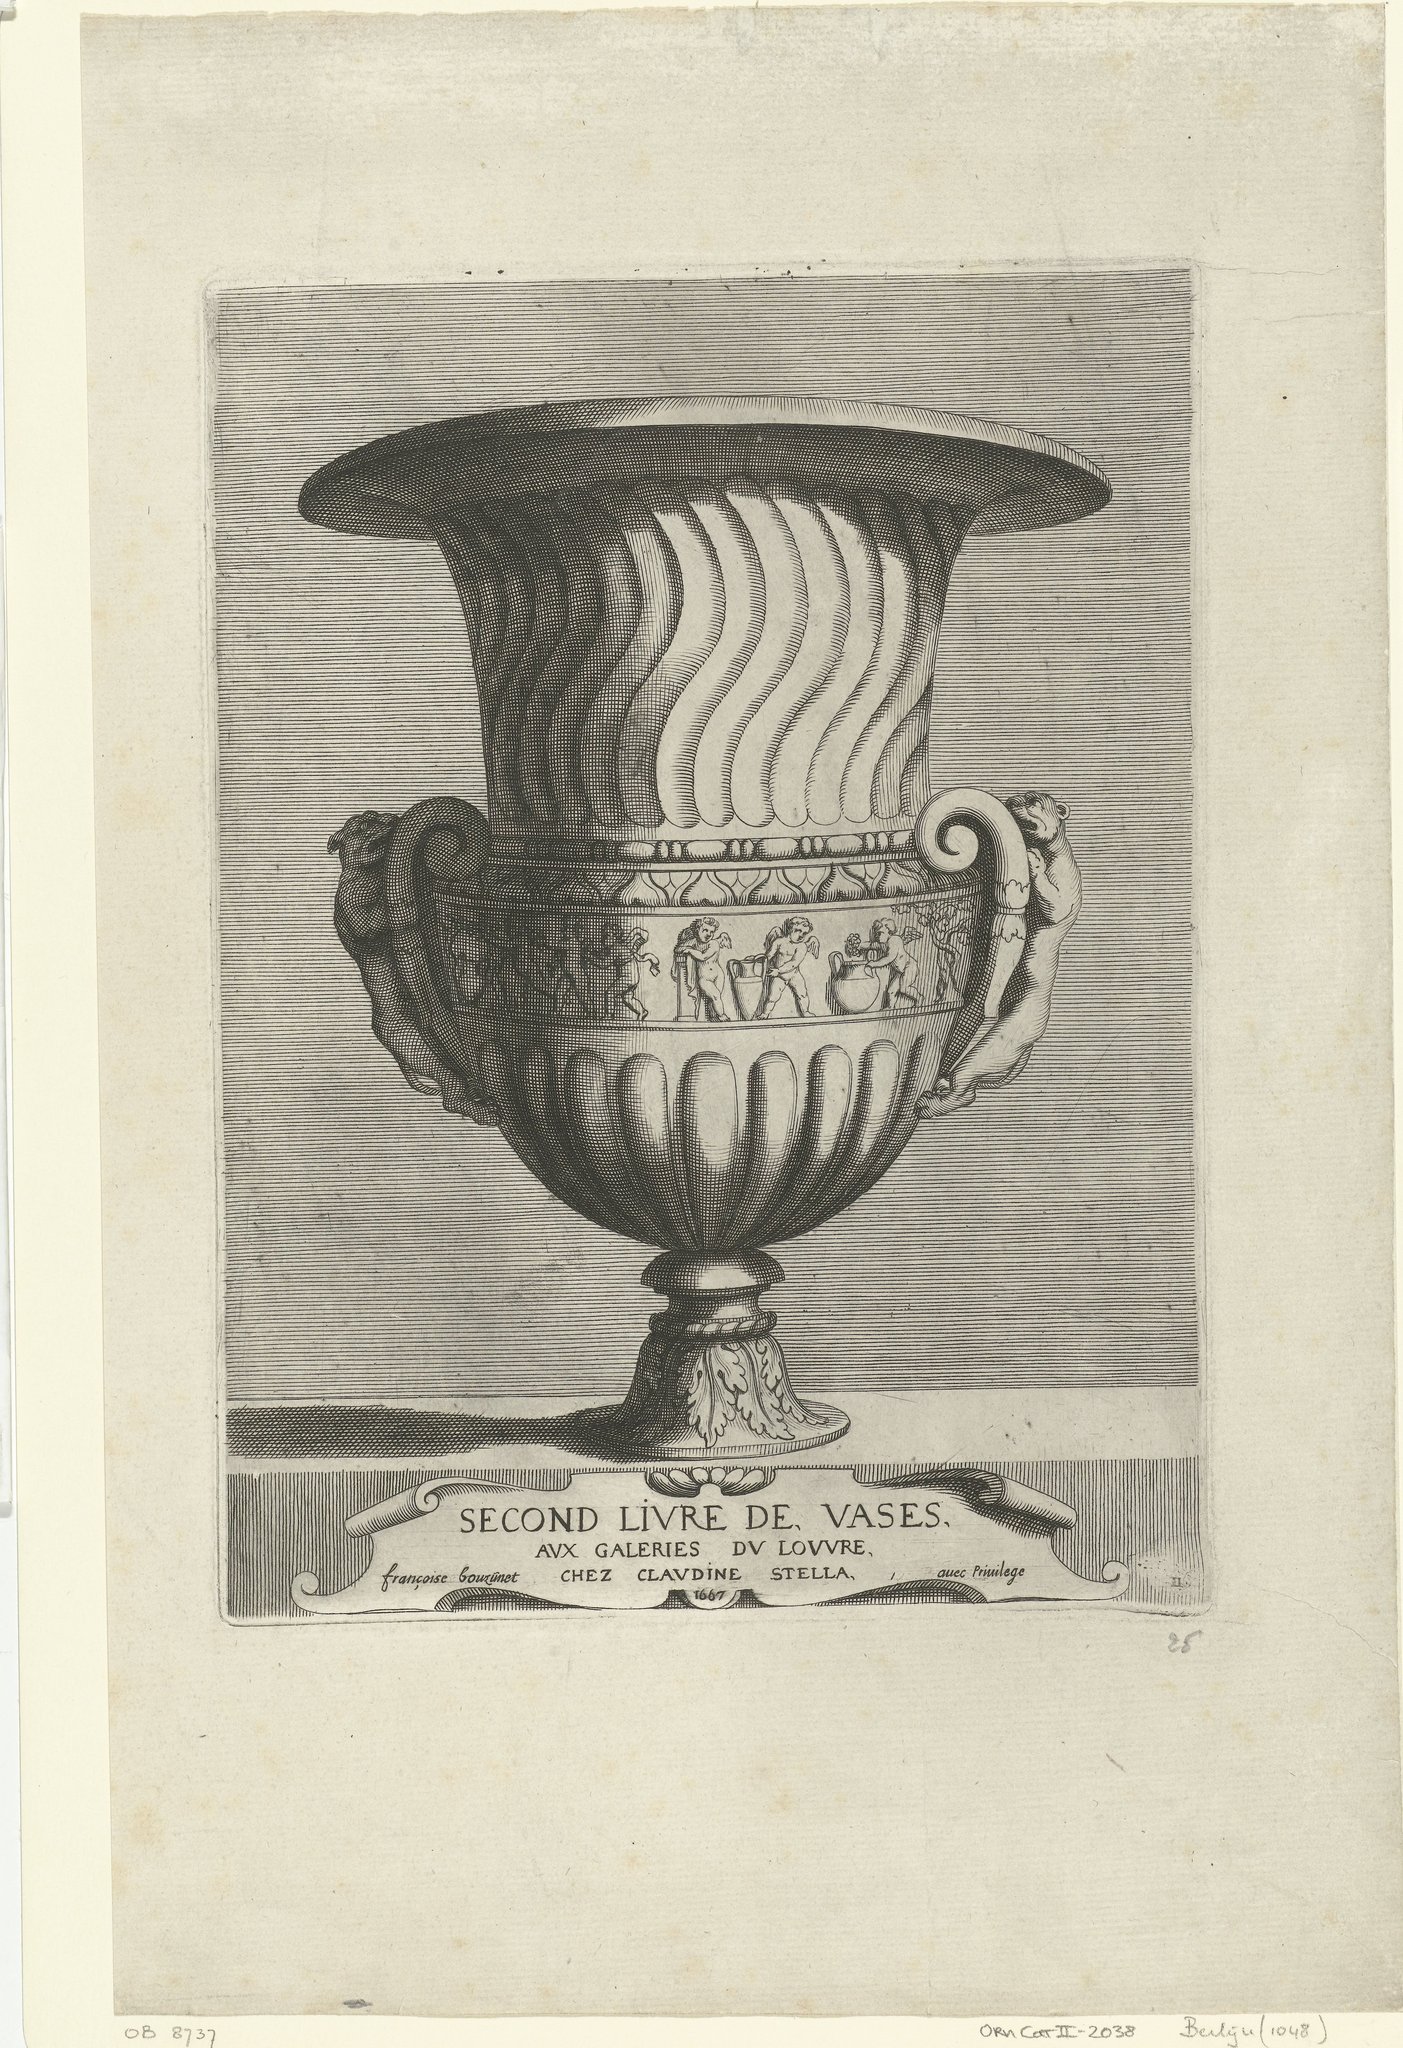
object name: print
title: Second Livre de Vases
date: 1667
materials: paper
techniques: engraving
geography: france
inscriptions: date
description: Vaas met uitwaaierende rand, een fries met putti en handvatten in de vorm van consoles met leeuwen. Rechtsonder staat het nummer II, daaronder is nog steeds het voormalige nummer 16 (of 26) te zien. Blad 26 uit serie van 25 bladen, genummerd: II (voorheen 26), 27-50.